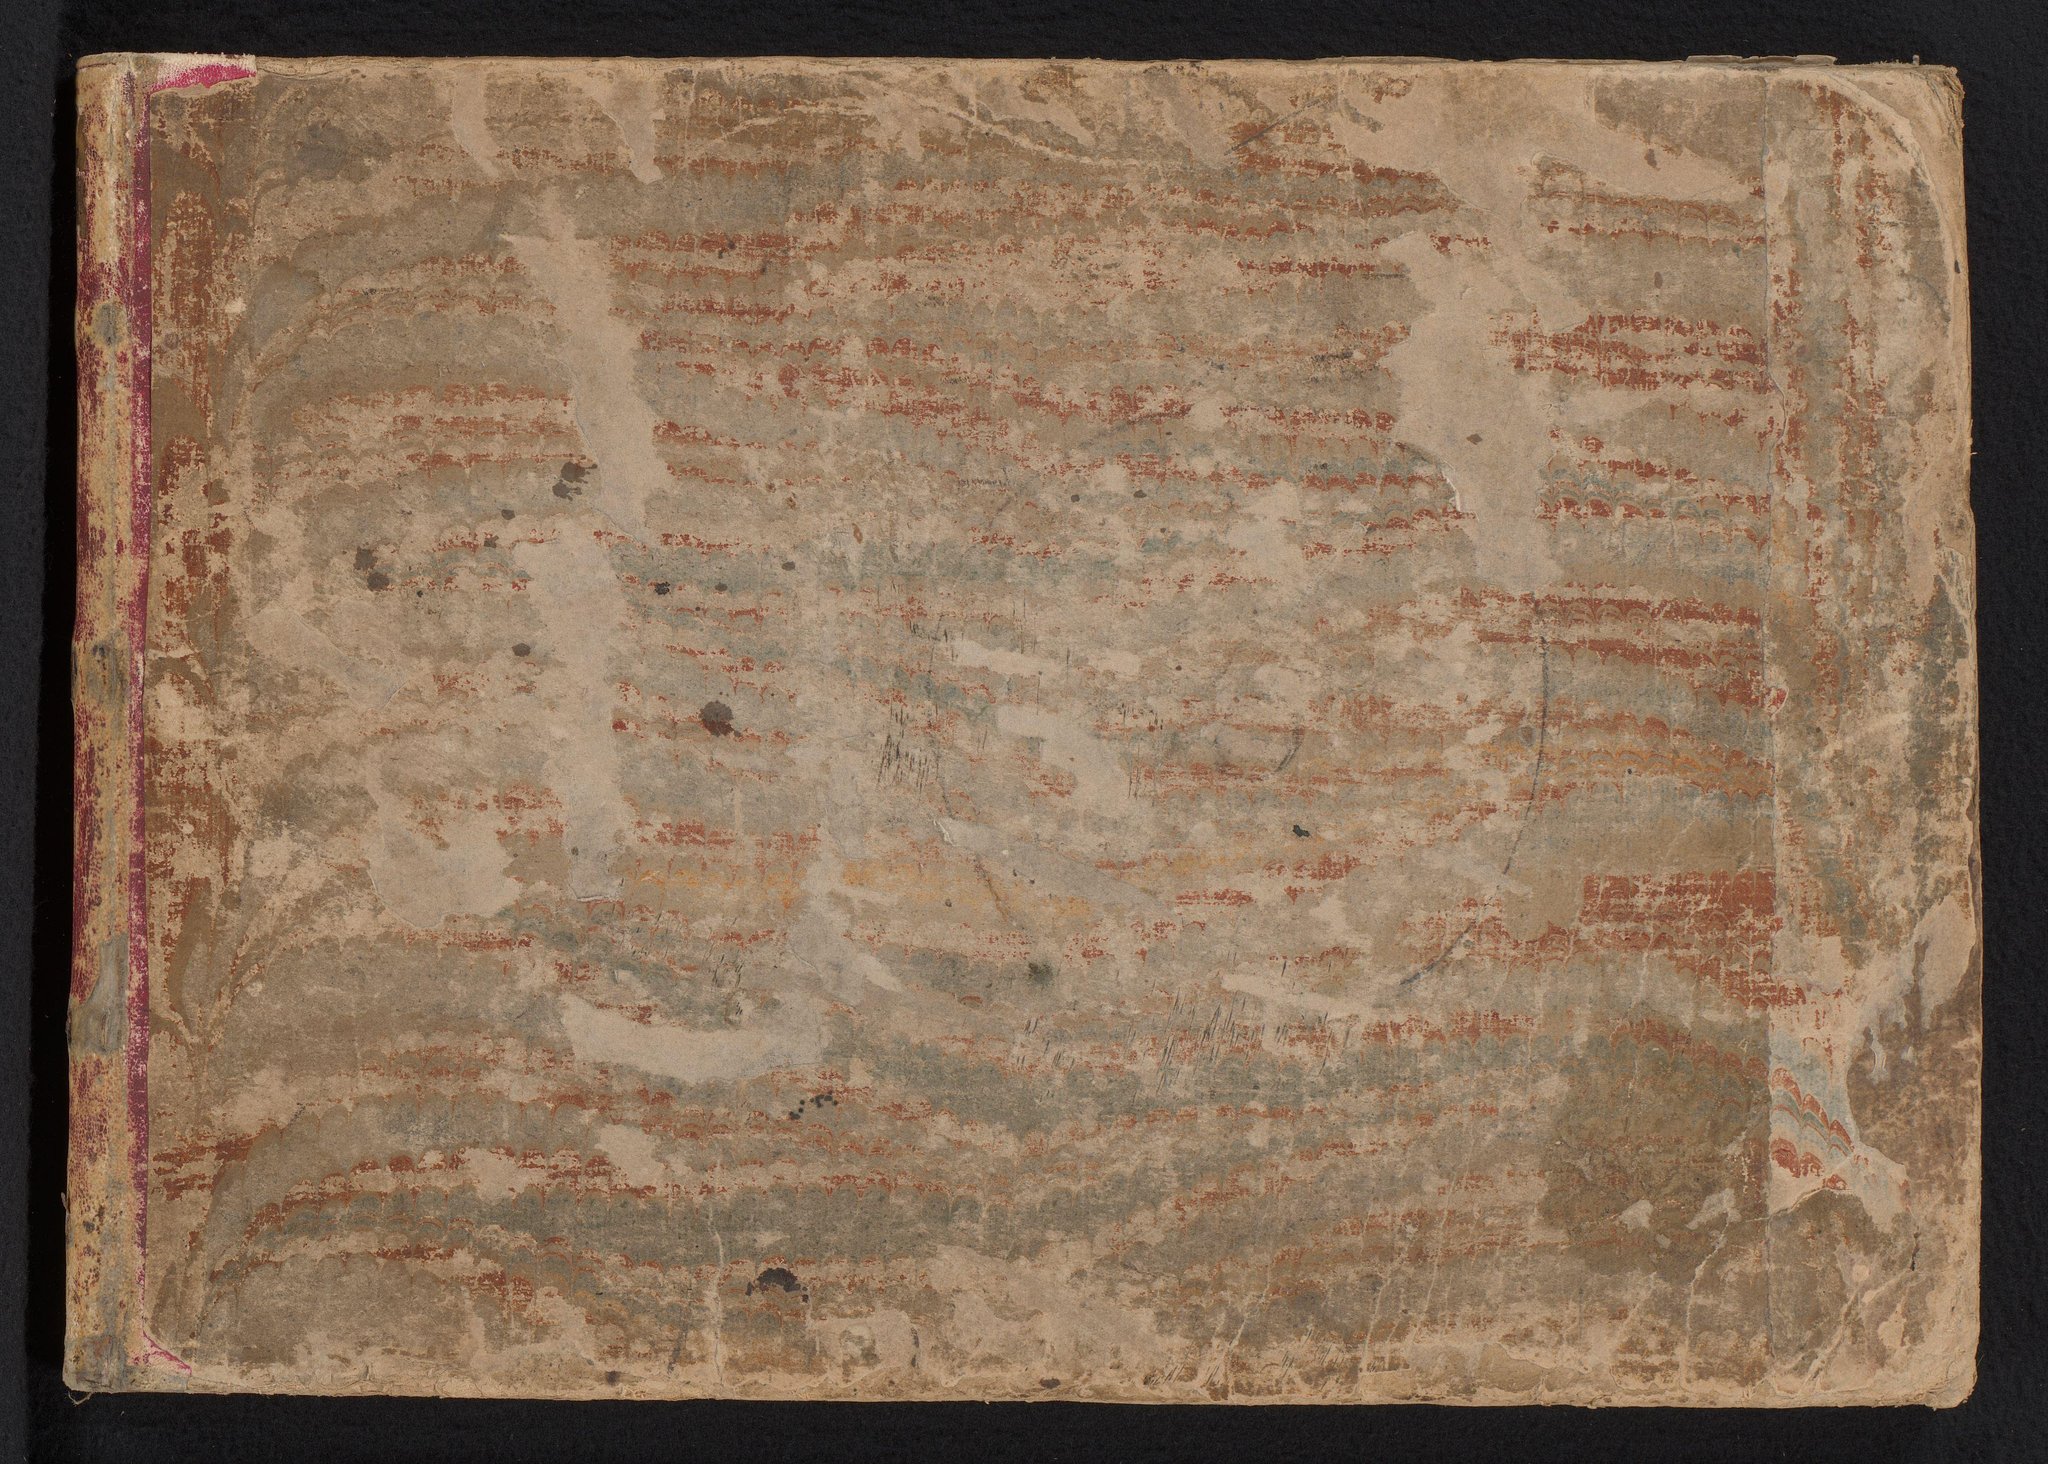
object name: writing book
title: Album met kalligrafische schrijfvoorbeelden en beschrijvingen van en instructies bij het schrijven van Spaanse, Italiaanse, Nederlandse, Franse, Engelse en Hoogduitse handen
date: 1605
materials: leather, paper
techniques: bookbinding, calligraphy, engraving, letterpress printing, marbling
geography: rotterdam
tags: calligraphy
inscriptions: collector's mark: Lugt 2228, collector's mark: Lugt 2760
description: De (tekst)bladen in dit album zijn verkeerd ingebonden. De tussentitel van het tweede deel (Thrésor litéraire) is gebonden voor de bladen van het derde deel. De tussentitel van het derde deel ontbreekt (het Fondement-Boeck), evenals twee schrijfvoorbeelden met de Hoogduitse letteren en de Nederlandse, Italiaanse en Spaanse kapitalen (katern I). Wel met de kalligrafische titelprent: Artificiosissimum Grammatices ...